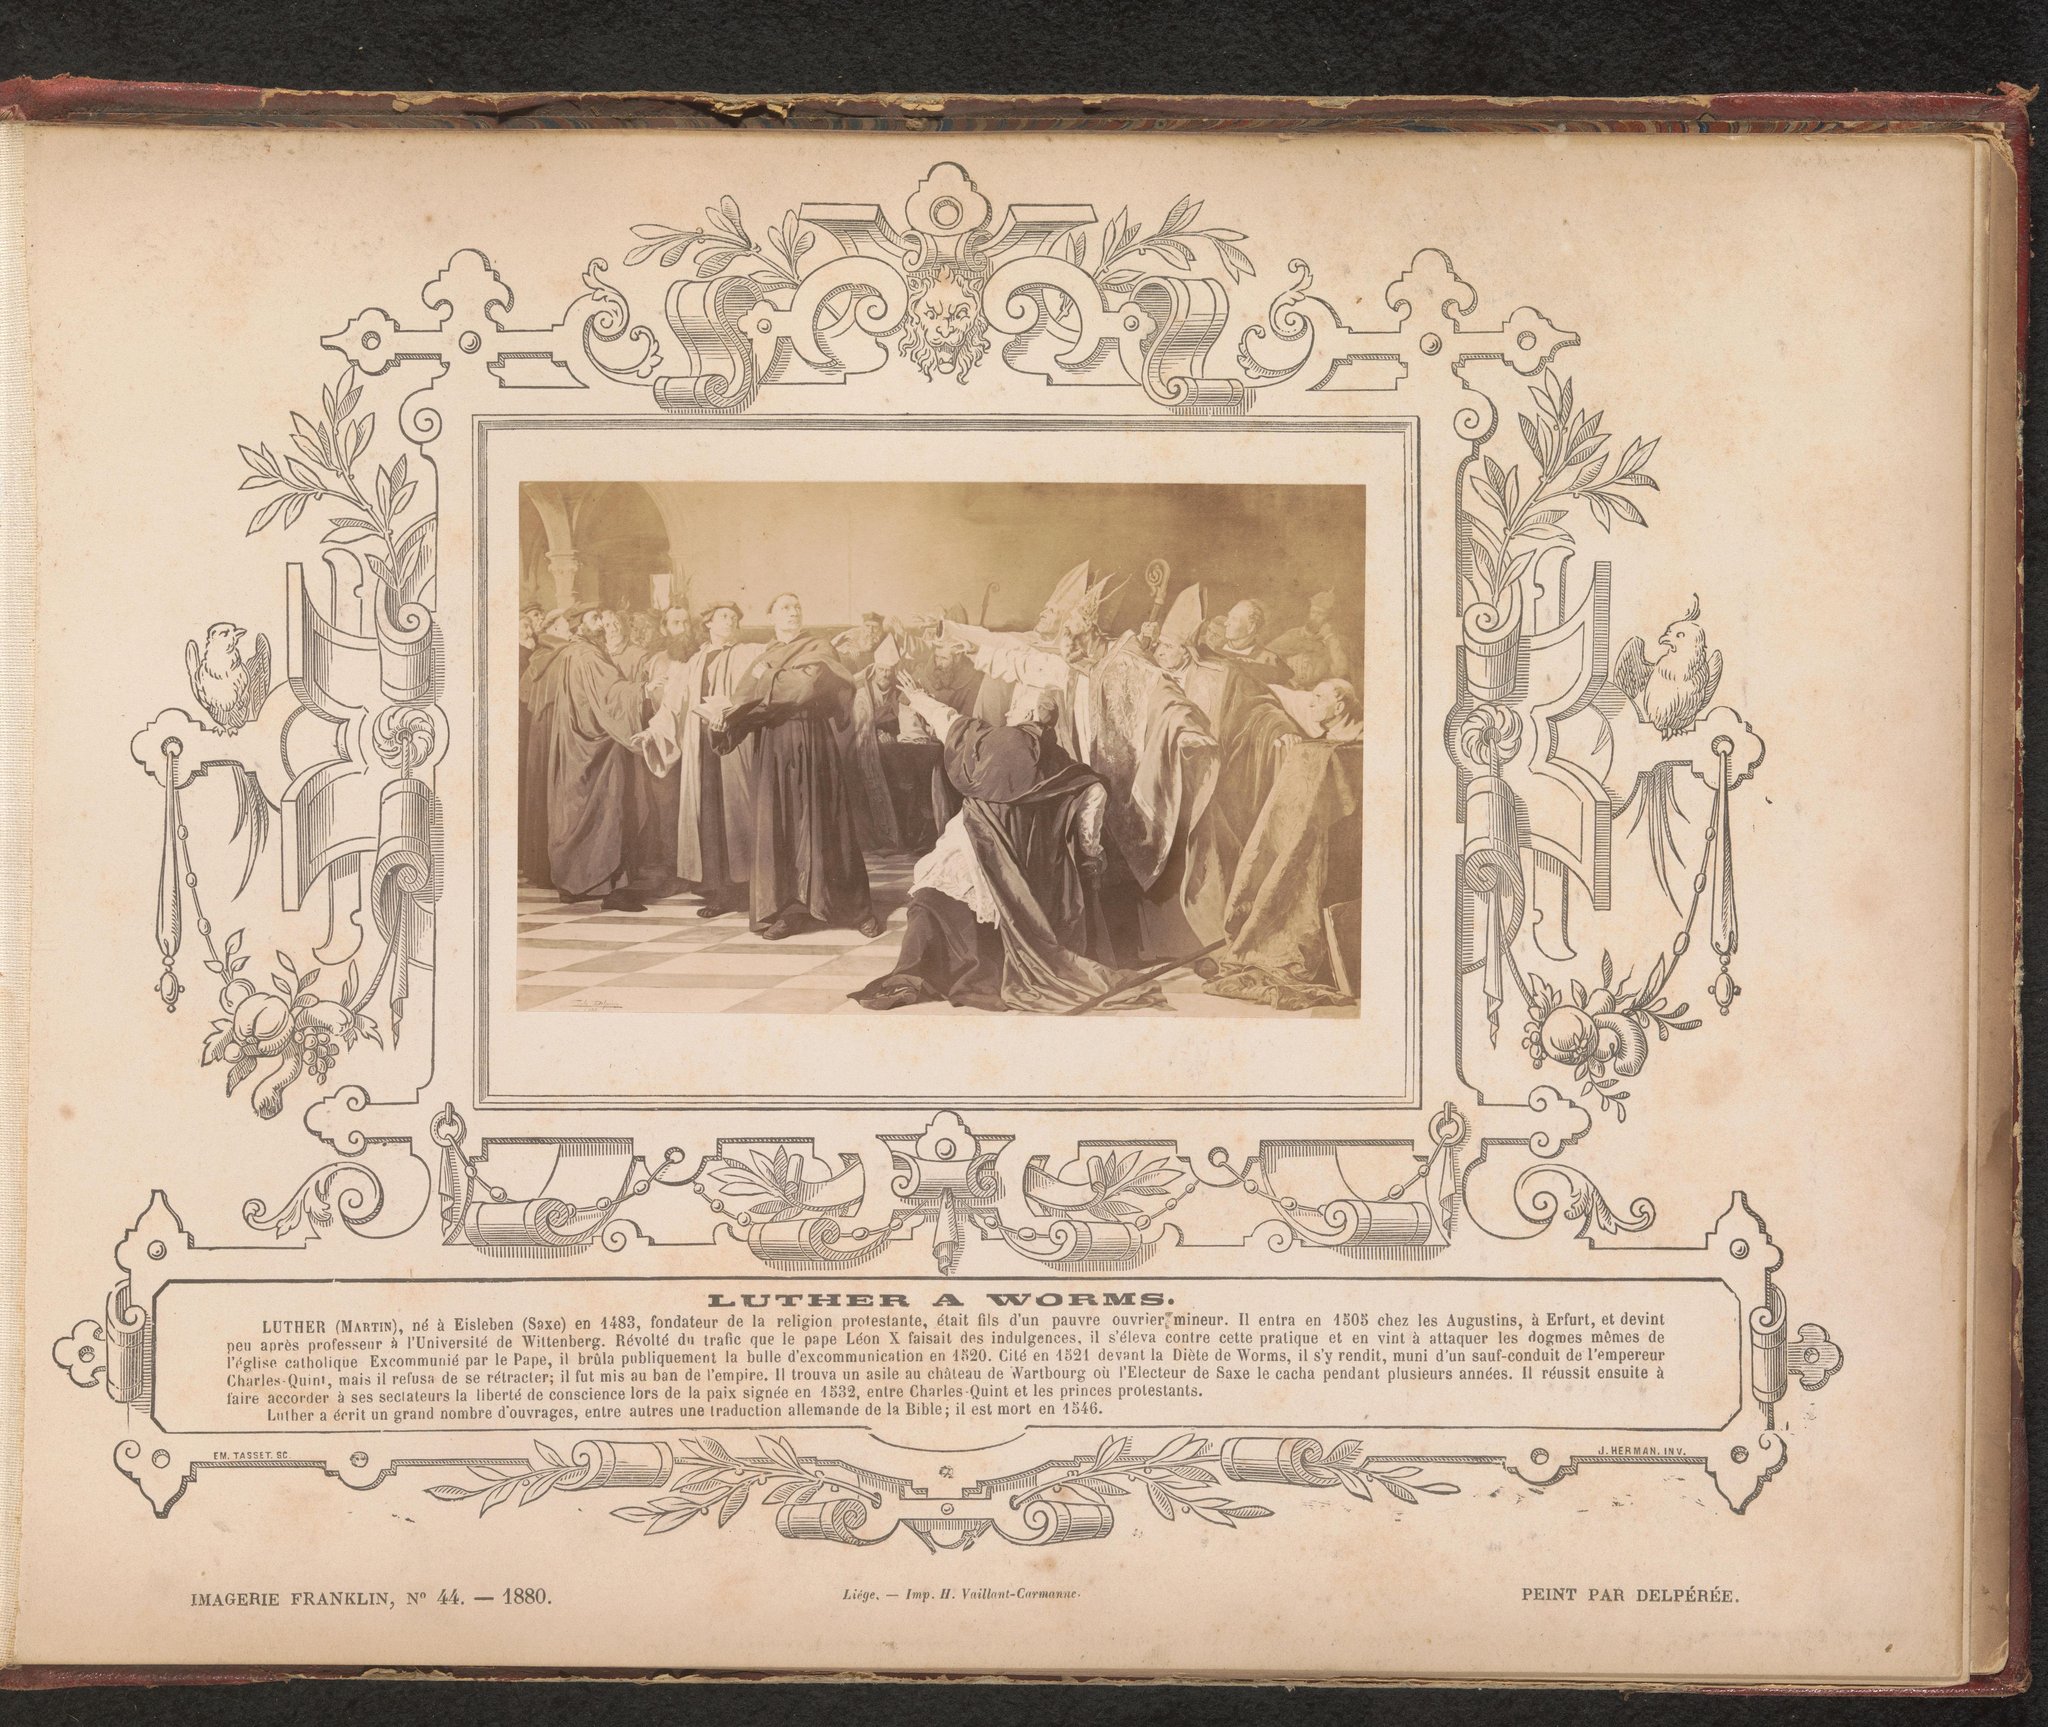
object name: photograph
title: Fotoreproductie van een schilderij van Luther op de rijksdag in Worms in 1521 door Émile Delpérée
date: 1875-1880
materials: photographic support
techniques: albumen print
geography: liège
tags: priest, martin luther, disputing theologians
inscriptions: name: ‘EM. TASSET, SC.’, inscription: ‘LUTHER (Martin) (...) en 1546.’, name: ‘J. HERMAN, INV.’, inscription: ‘IMAGERIE FRANKLIN No 44. - 1880.’